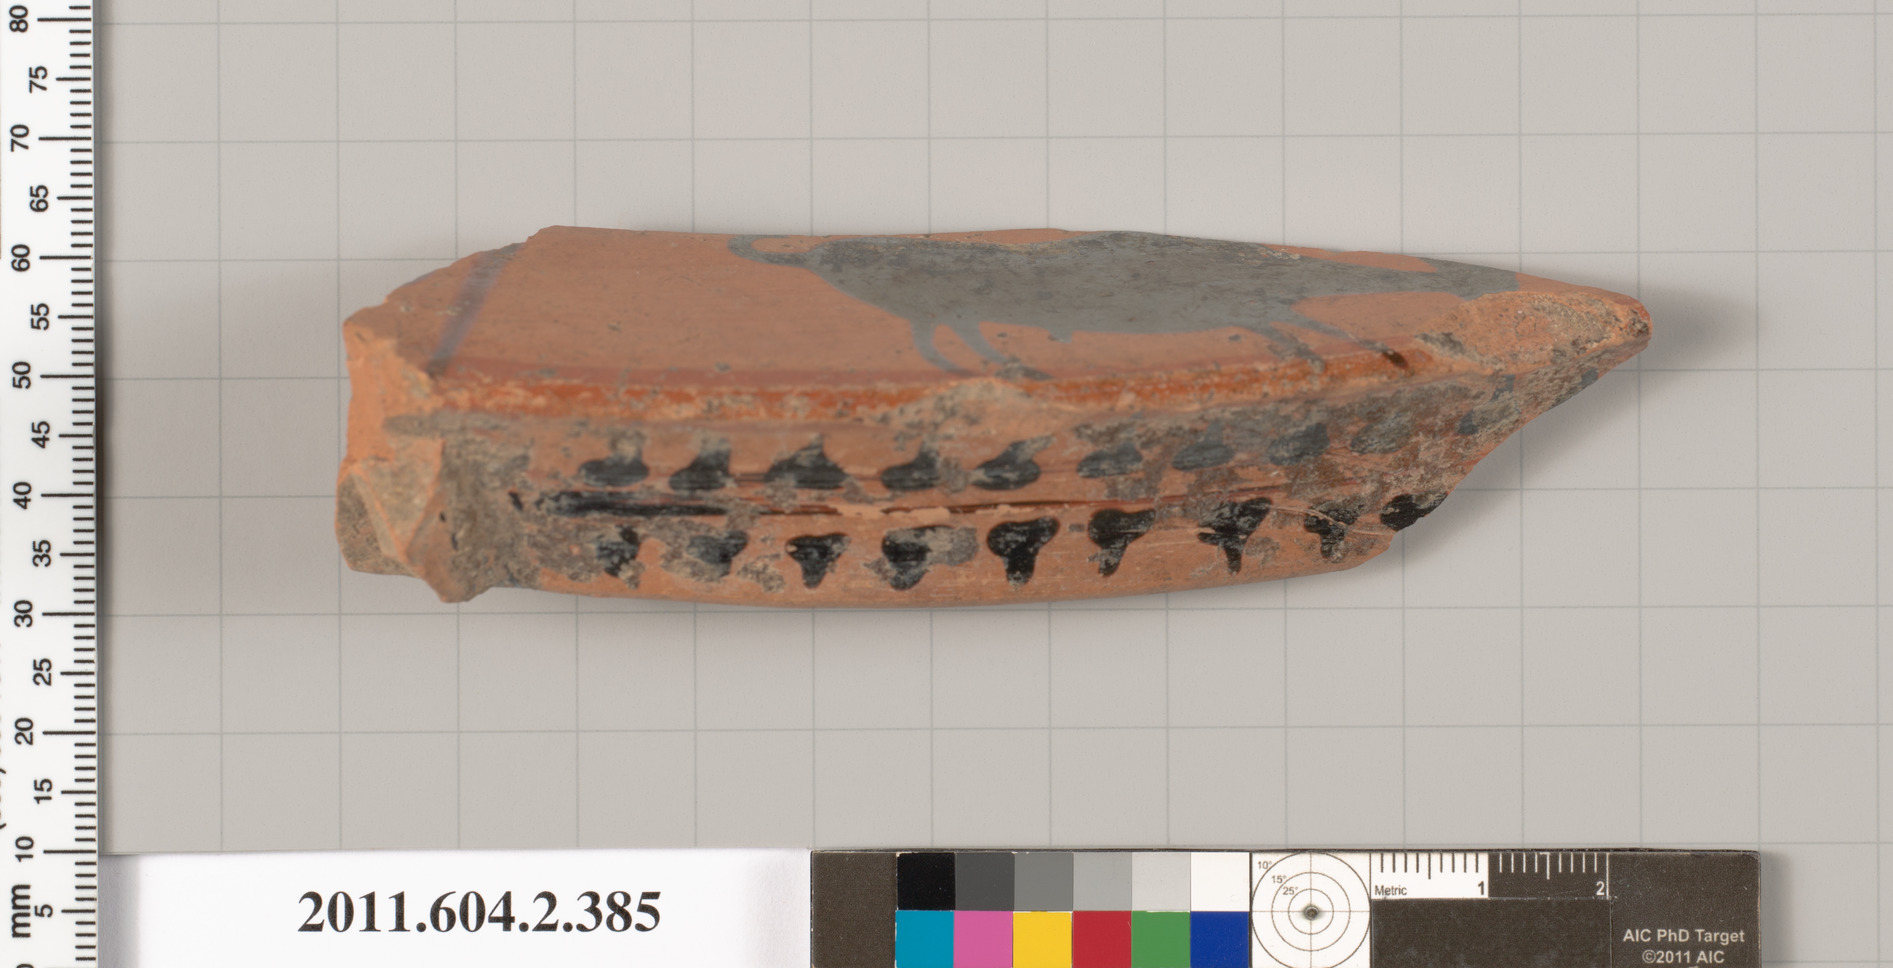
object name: column krater fragment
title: Terracotta fragment of a column-krater (bowl for mixing wine and water)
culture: greek, attic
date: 467-435 BCE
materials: terracotta